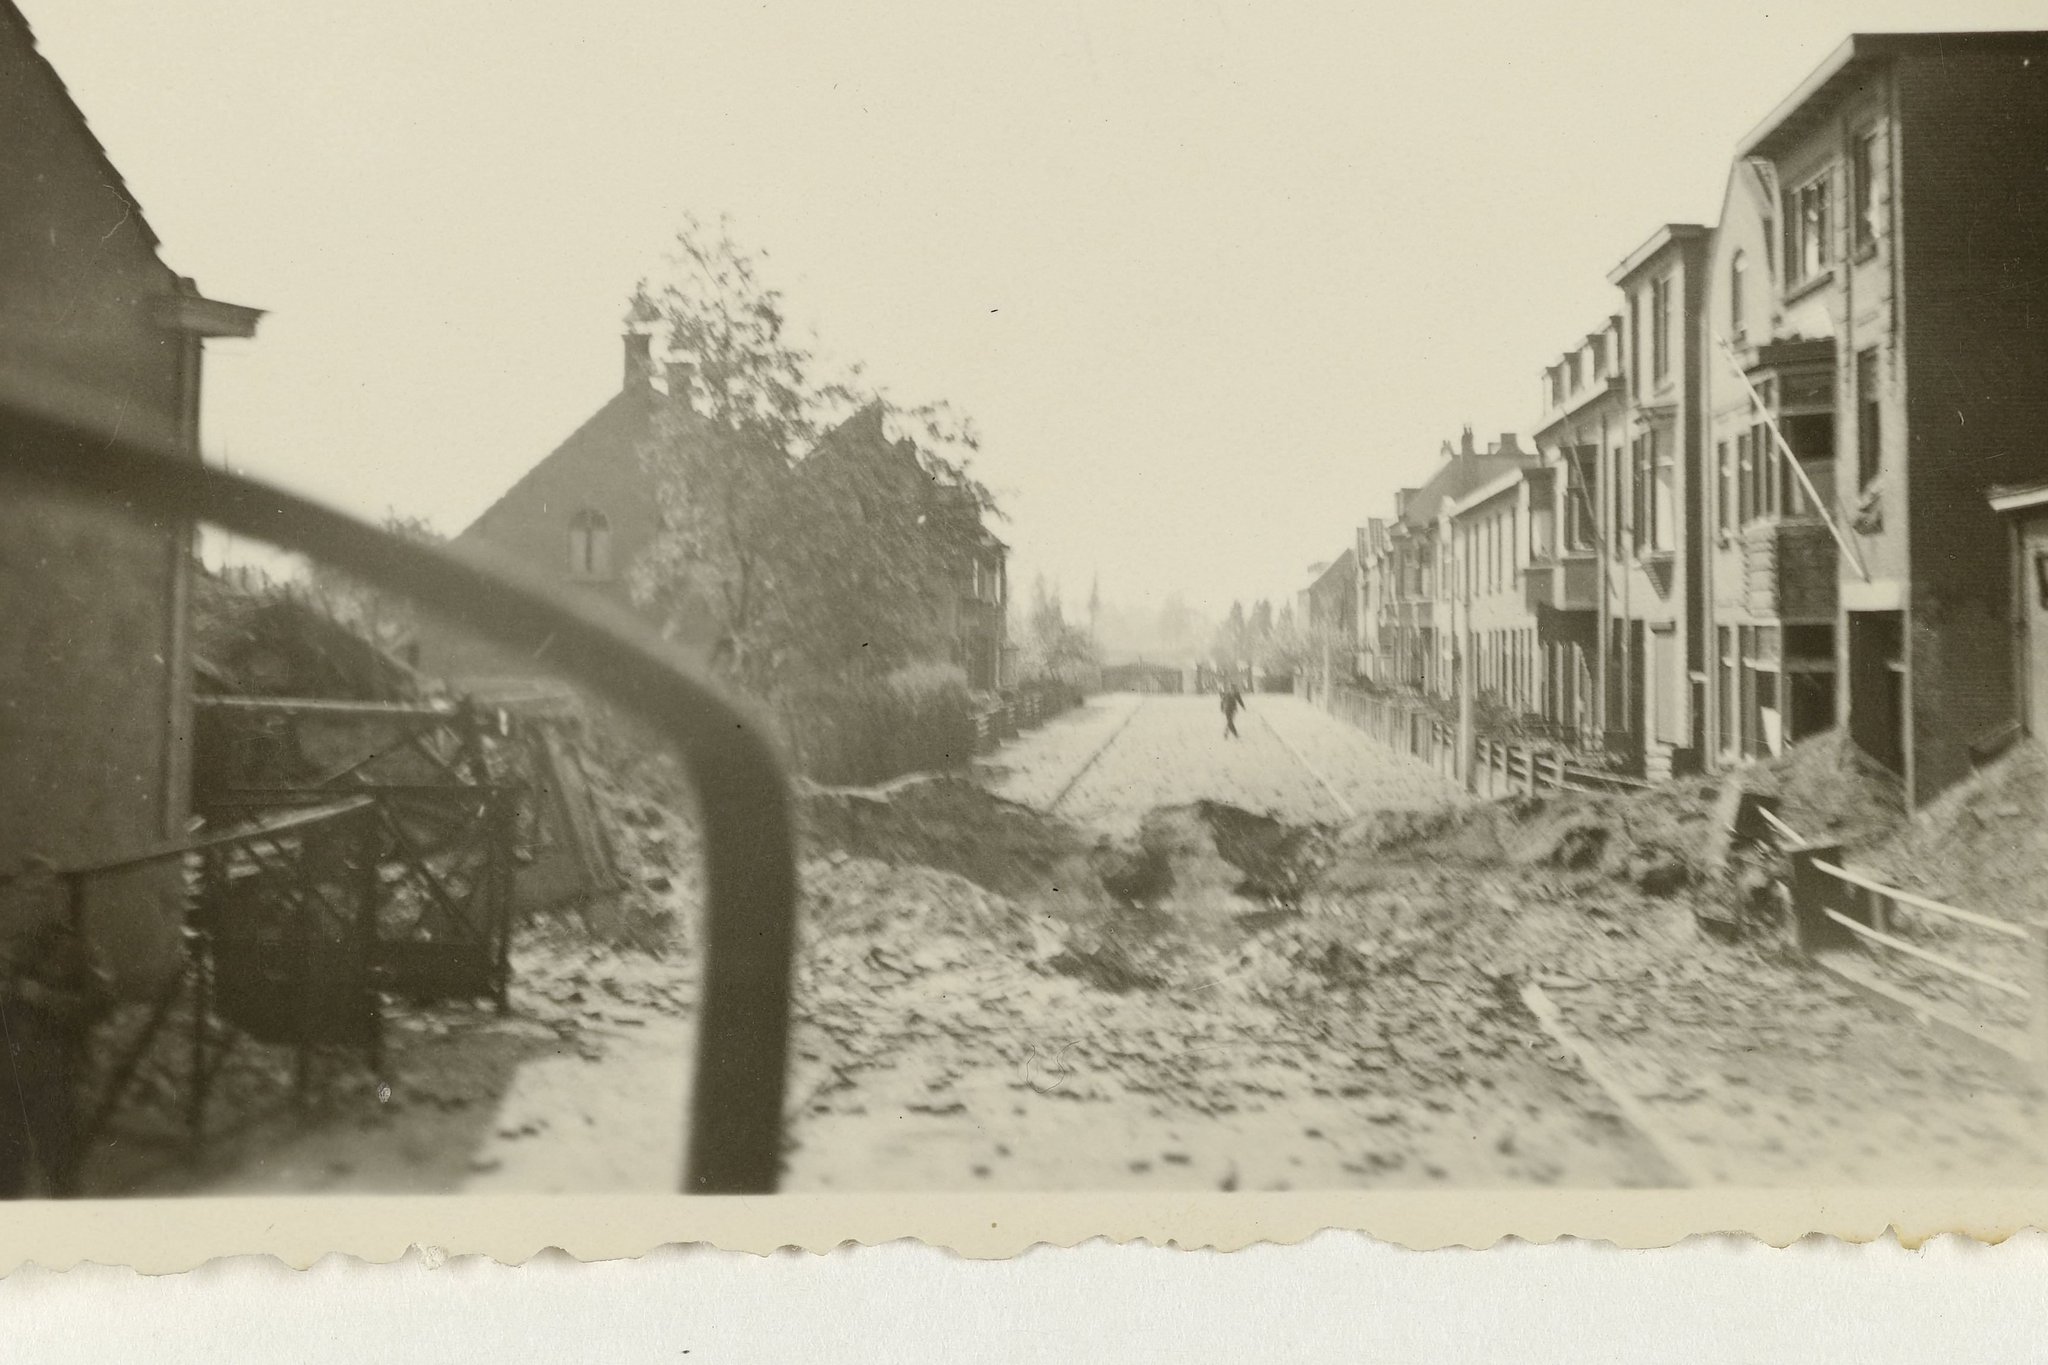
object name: photograph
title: Bomkrater in een weg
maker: Anonymous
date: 1940-1942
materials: photographic support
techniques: gelatin silver print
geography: netherlands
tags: devastated, ruined place or city (~ warfare), occupation ~ war, netherlands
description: In een dorp met een paar deels verwoeste huizen is midden in de weg een bomkrater zichtbaar.